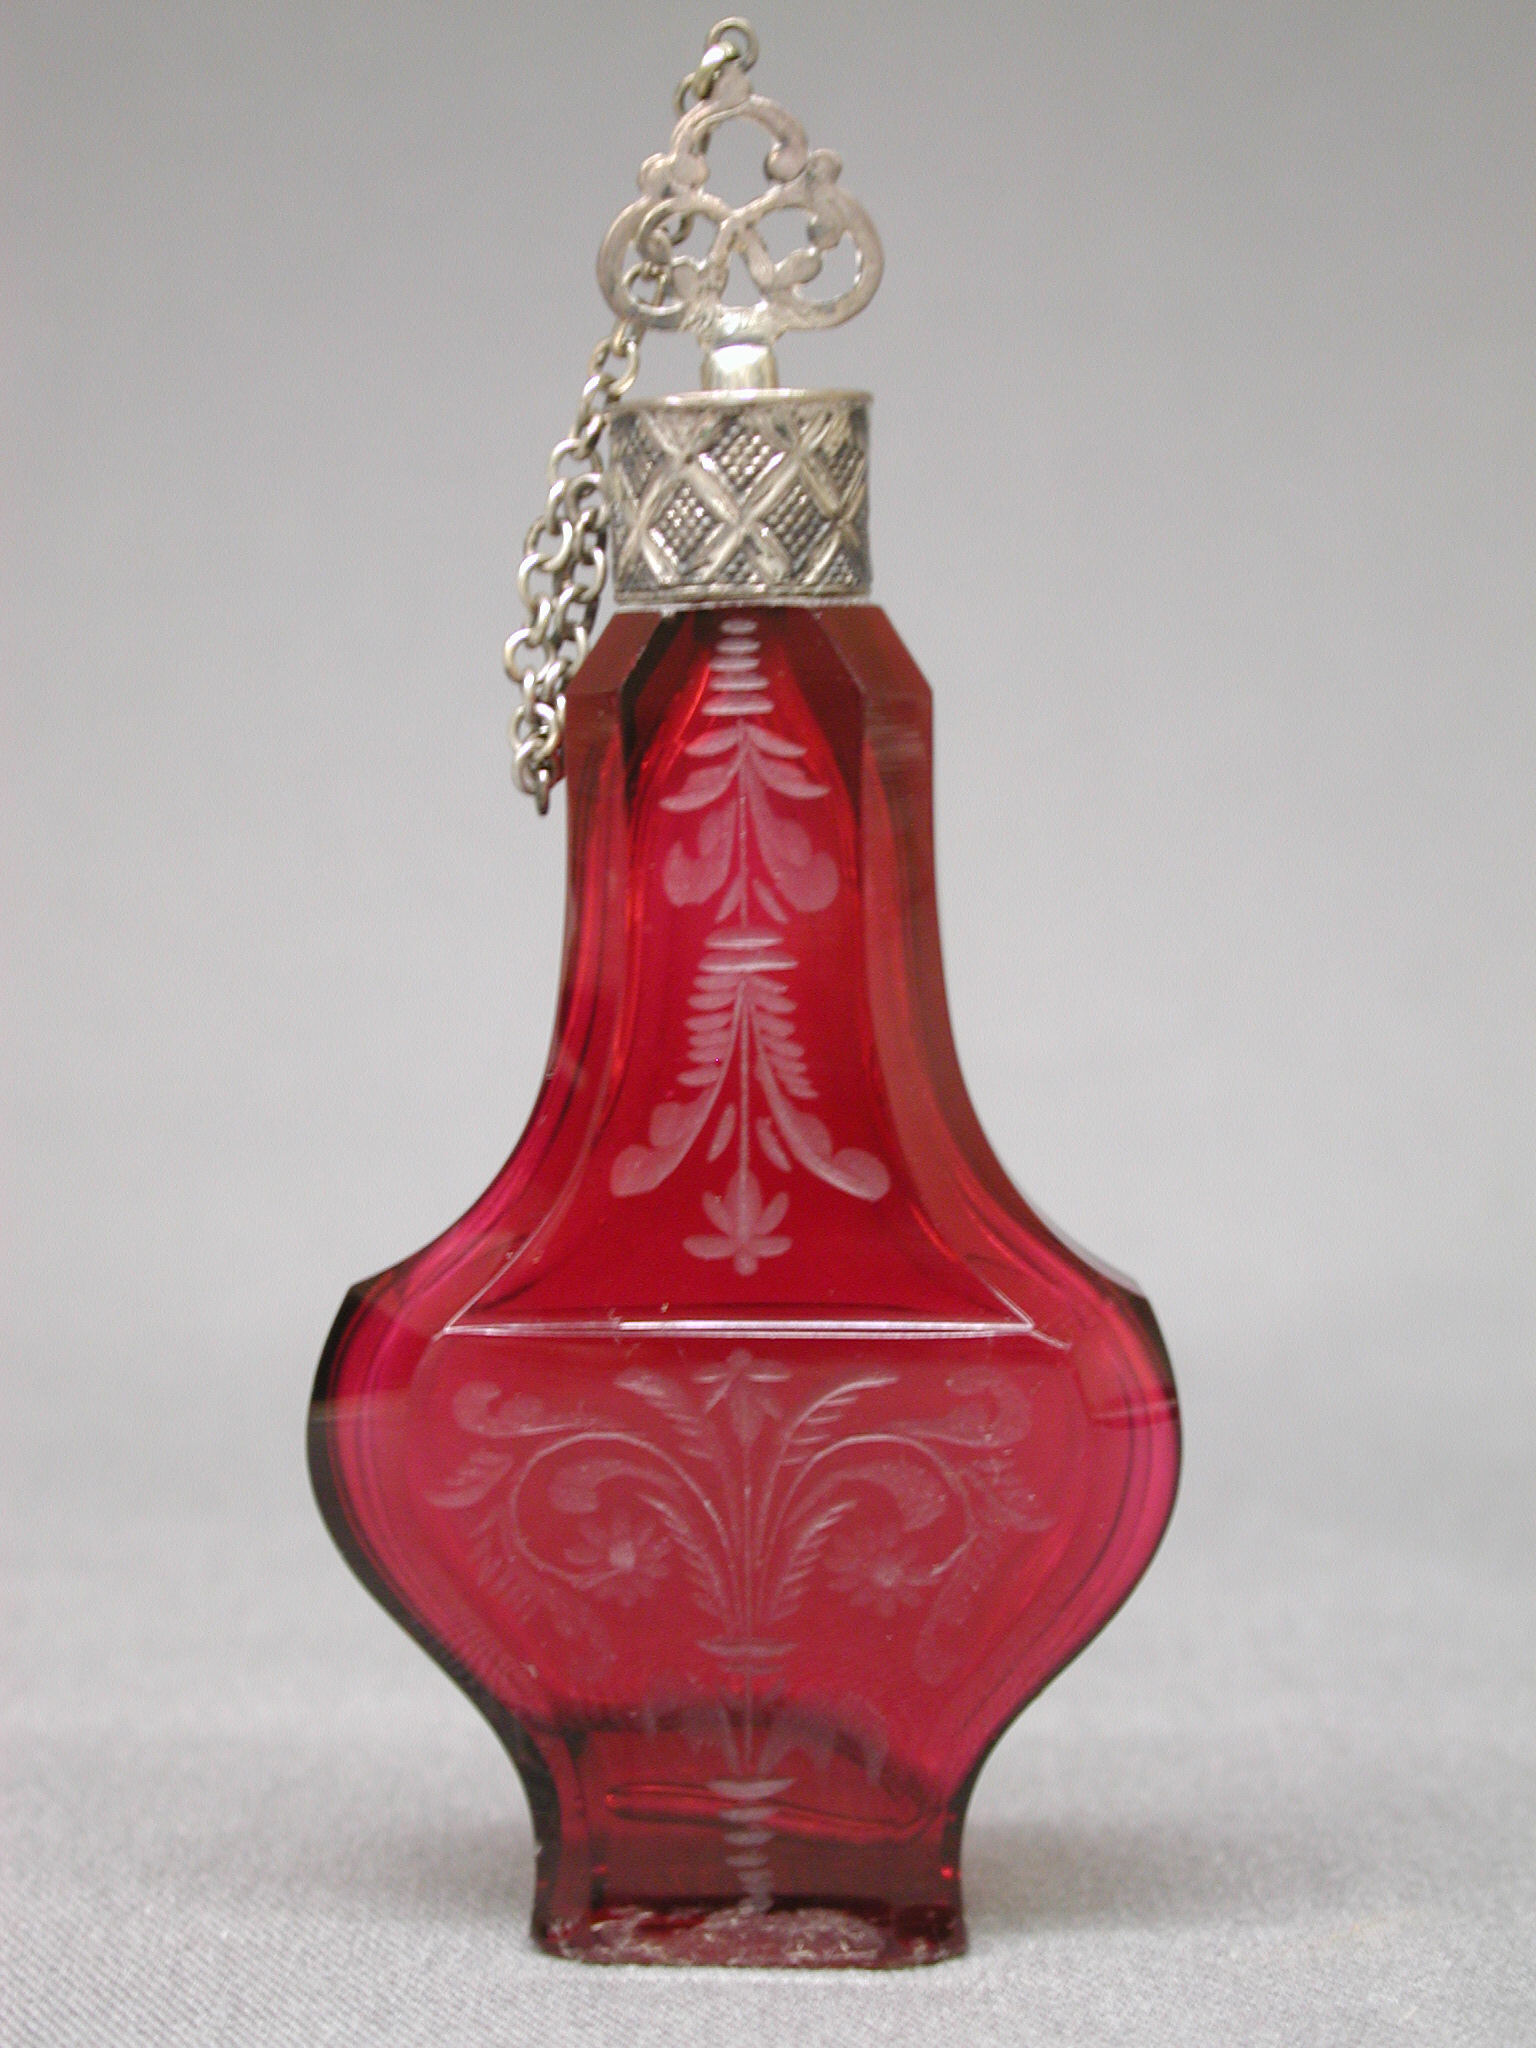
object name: scent bottle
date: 1750-1800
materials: glass, silver